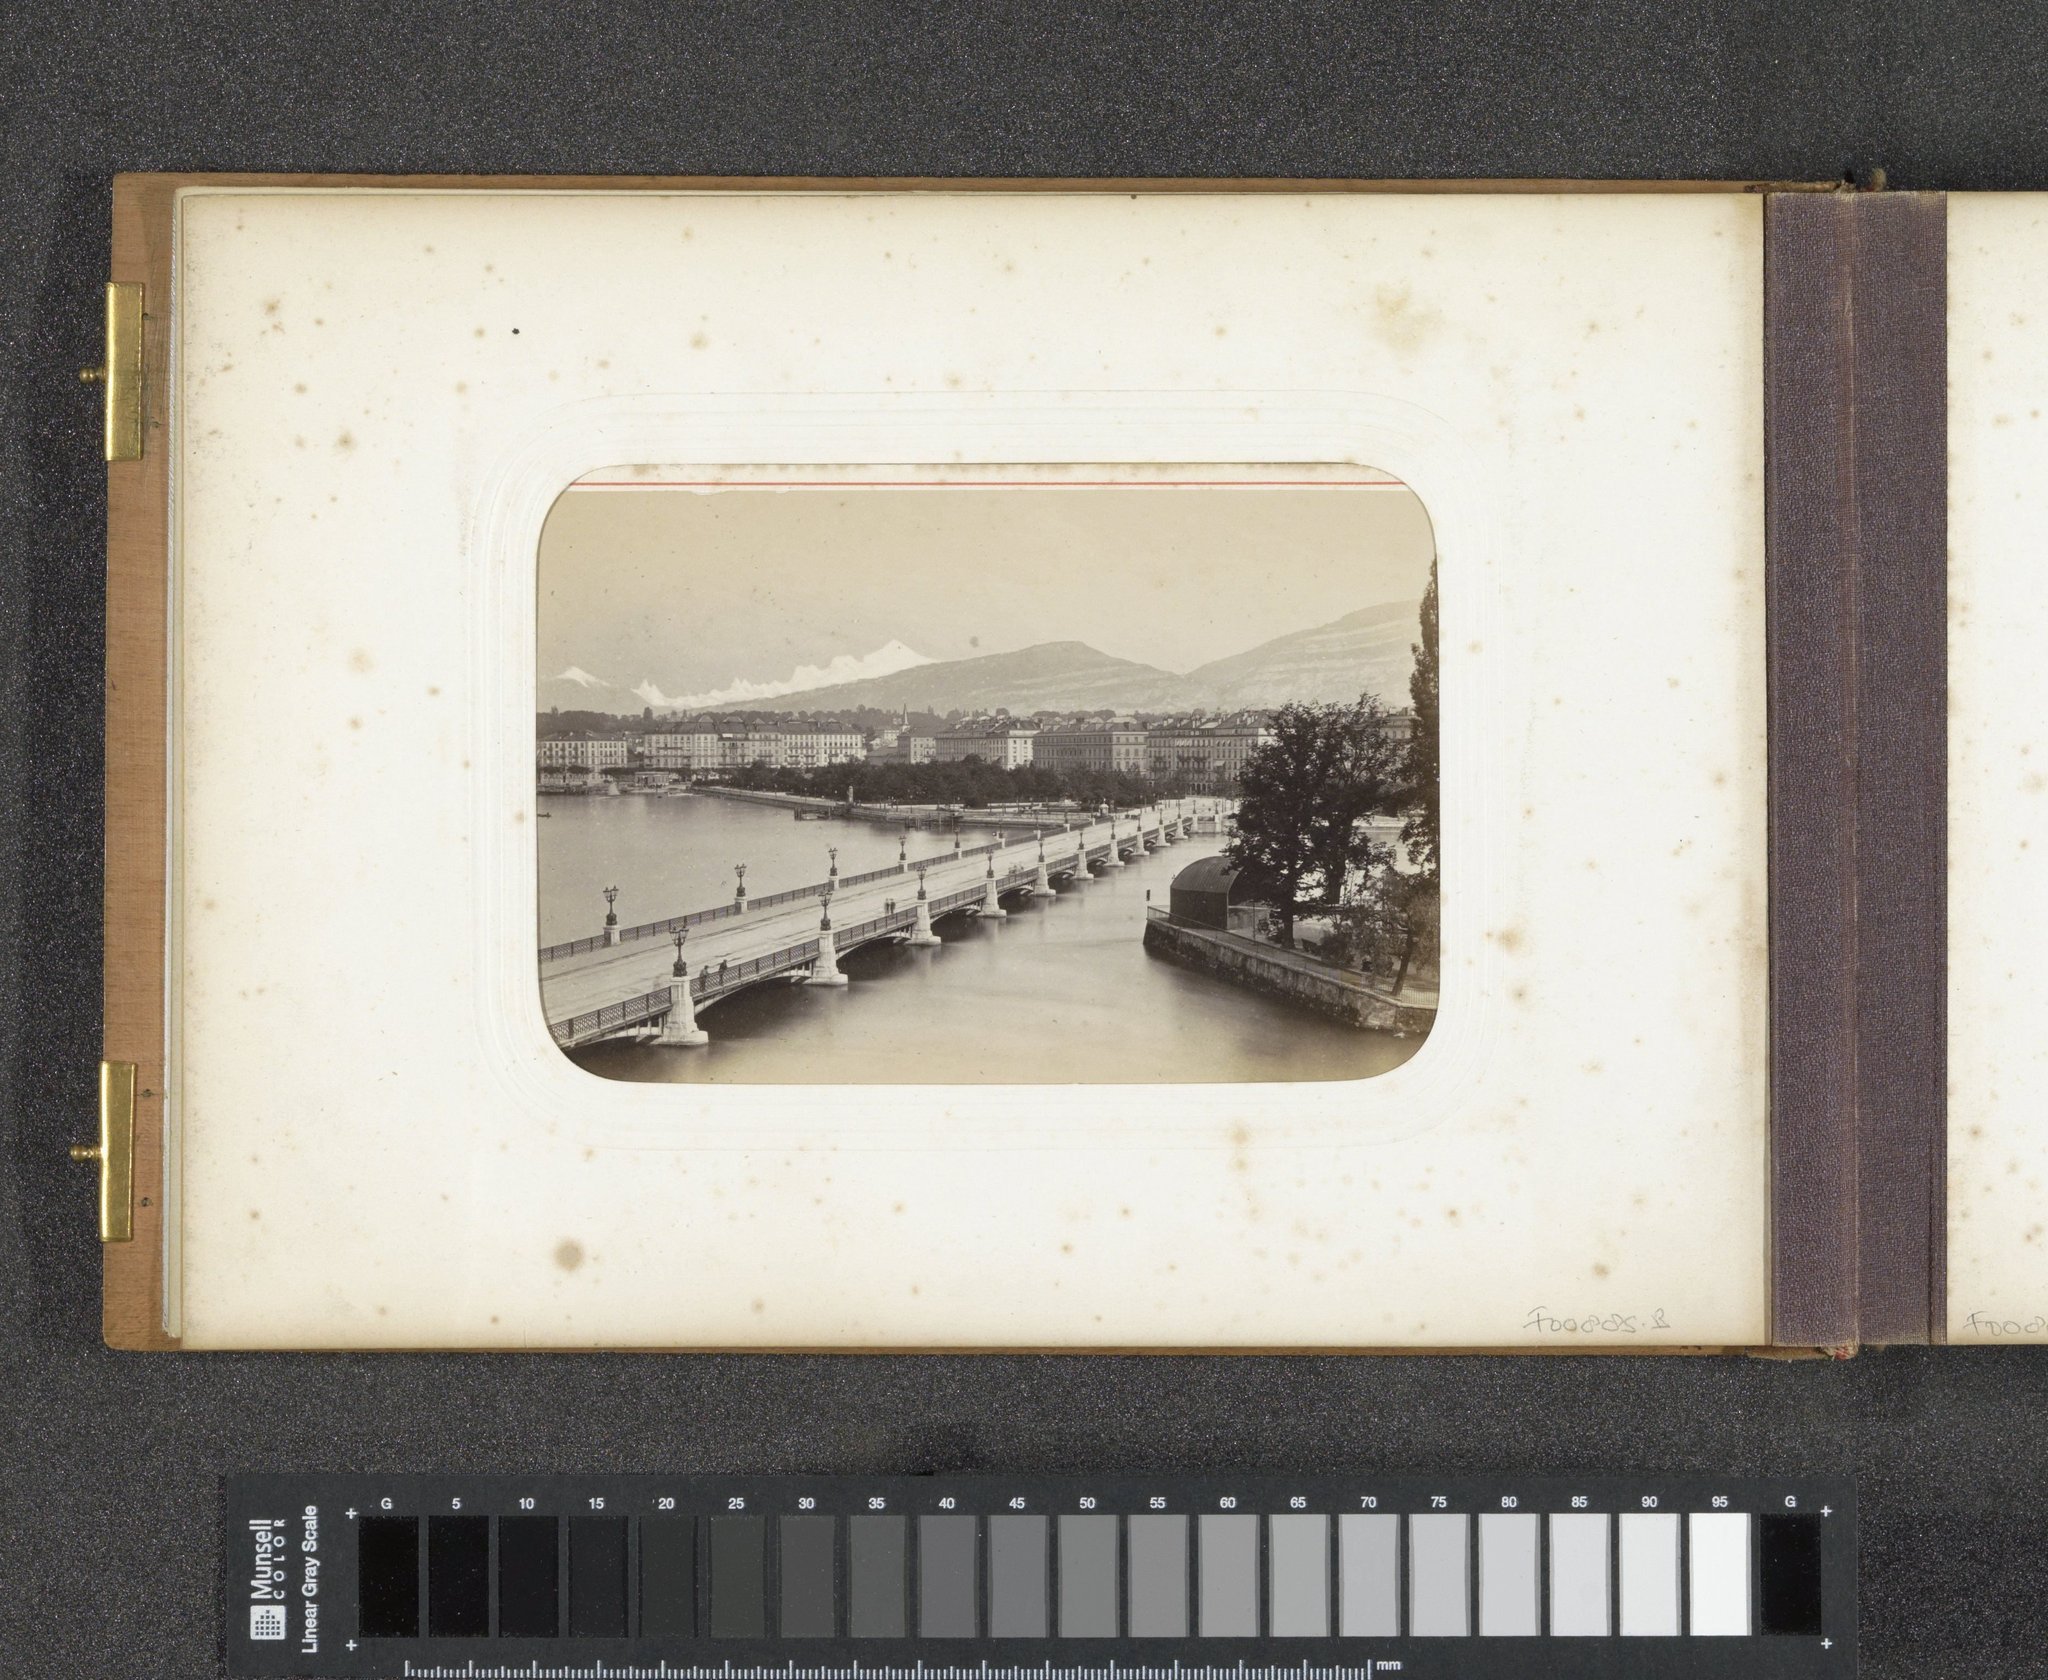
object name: album leaf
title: Genève et le Mont-Blanc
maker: auguste garcin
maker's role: fotograaf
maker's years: 1816-1895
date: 1860-1880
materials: cardboard, paper, photographic support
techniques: albumen print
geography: geneva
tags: bridge in city across river, canal, etc., prospect of city, town panorama, silhouette of city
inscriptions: number: ‘5’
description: Onderdeel van Reisalbum met bezienswaardigheden in de Zwitserse Alpen.